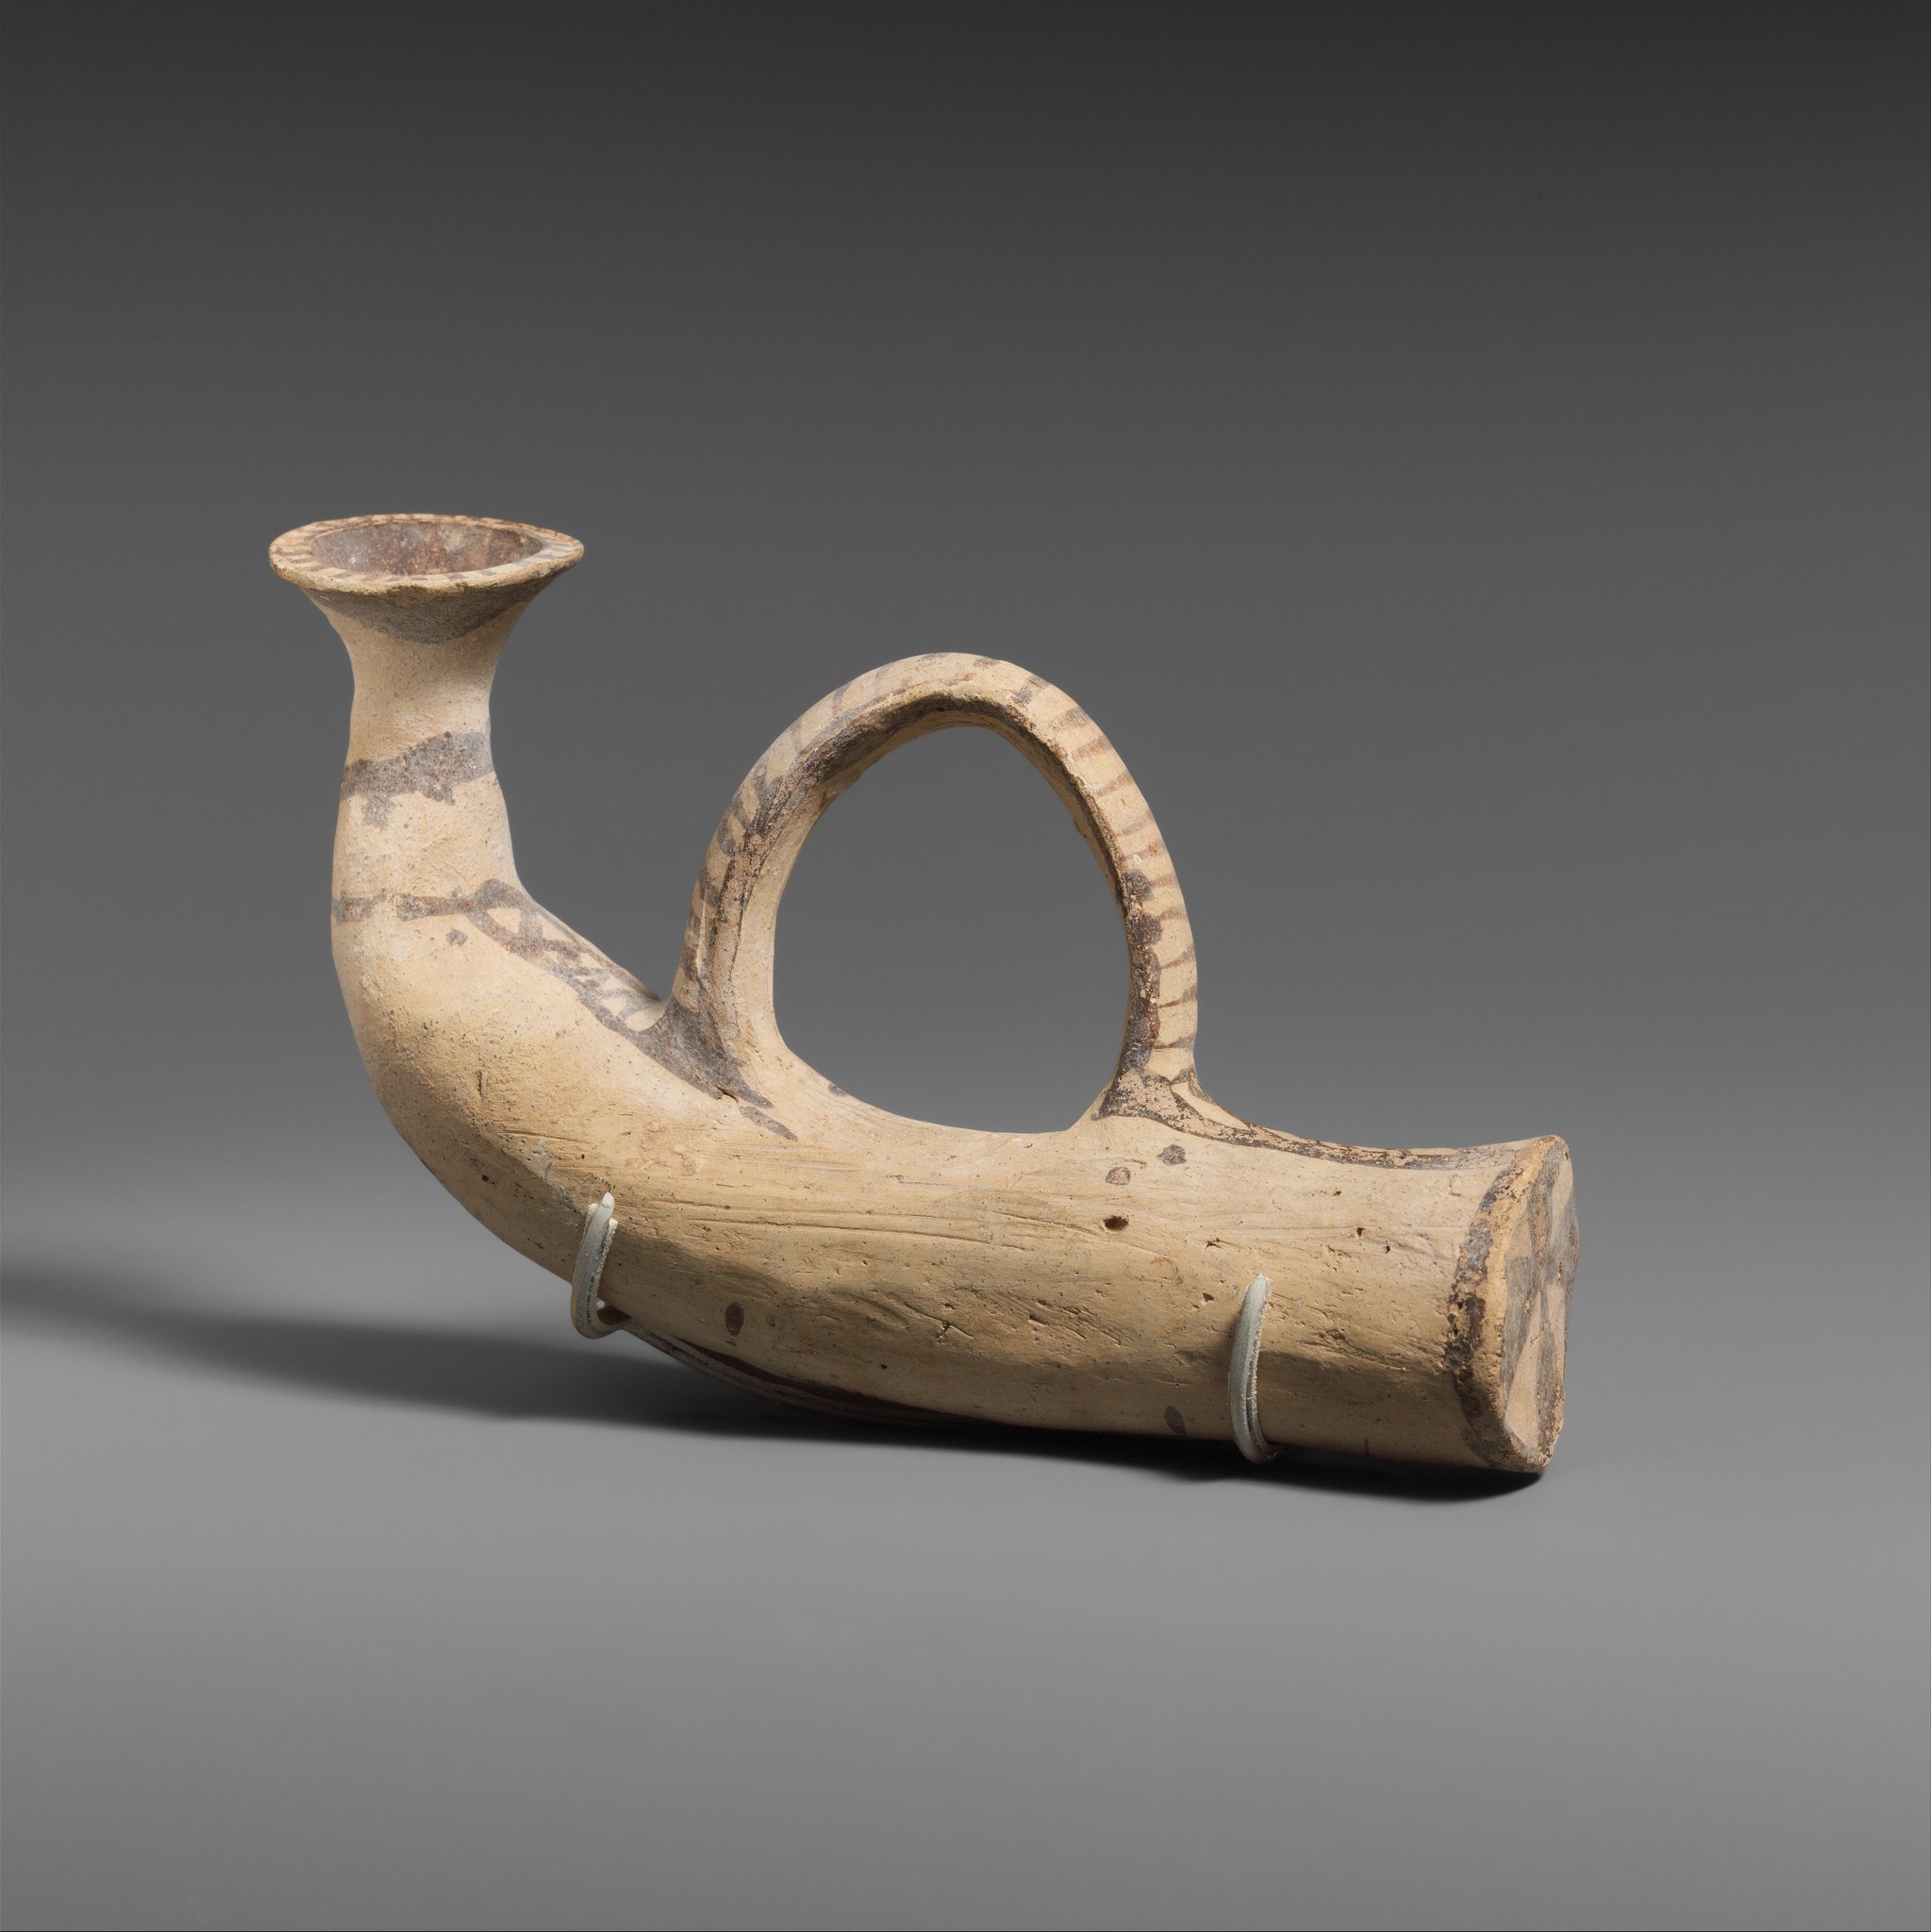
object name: juglet in the form of a horn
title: Terracotta vase in the shape of a horn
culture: cypriot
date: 1050-950 BCE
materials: terracotta